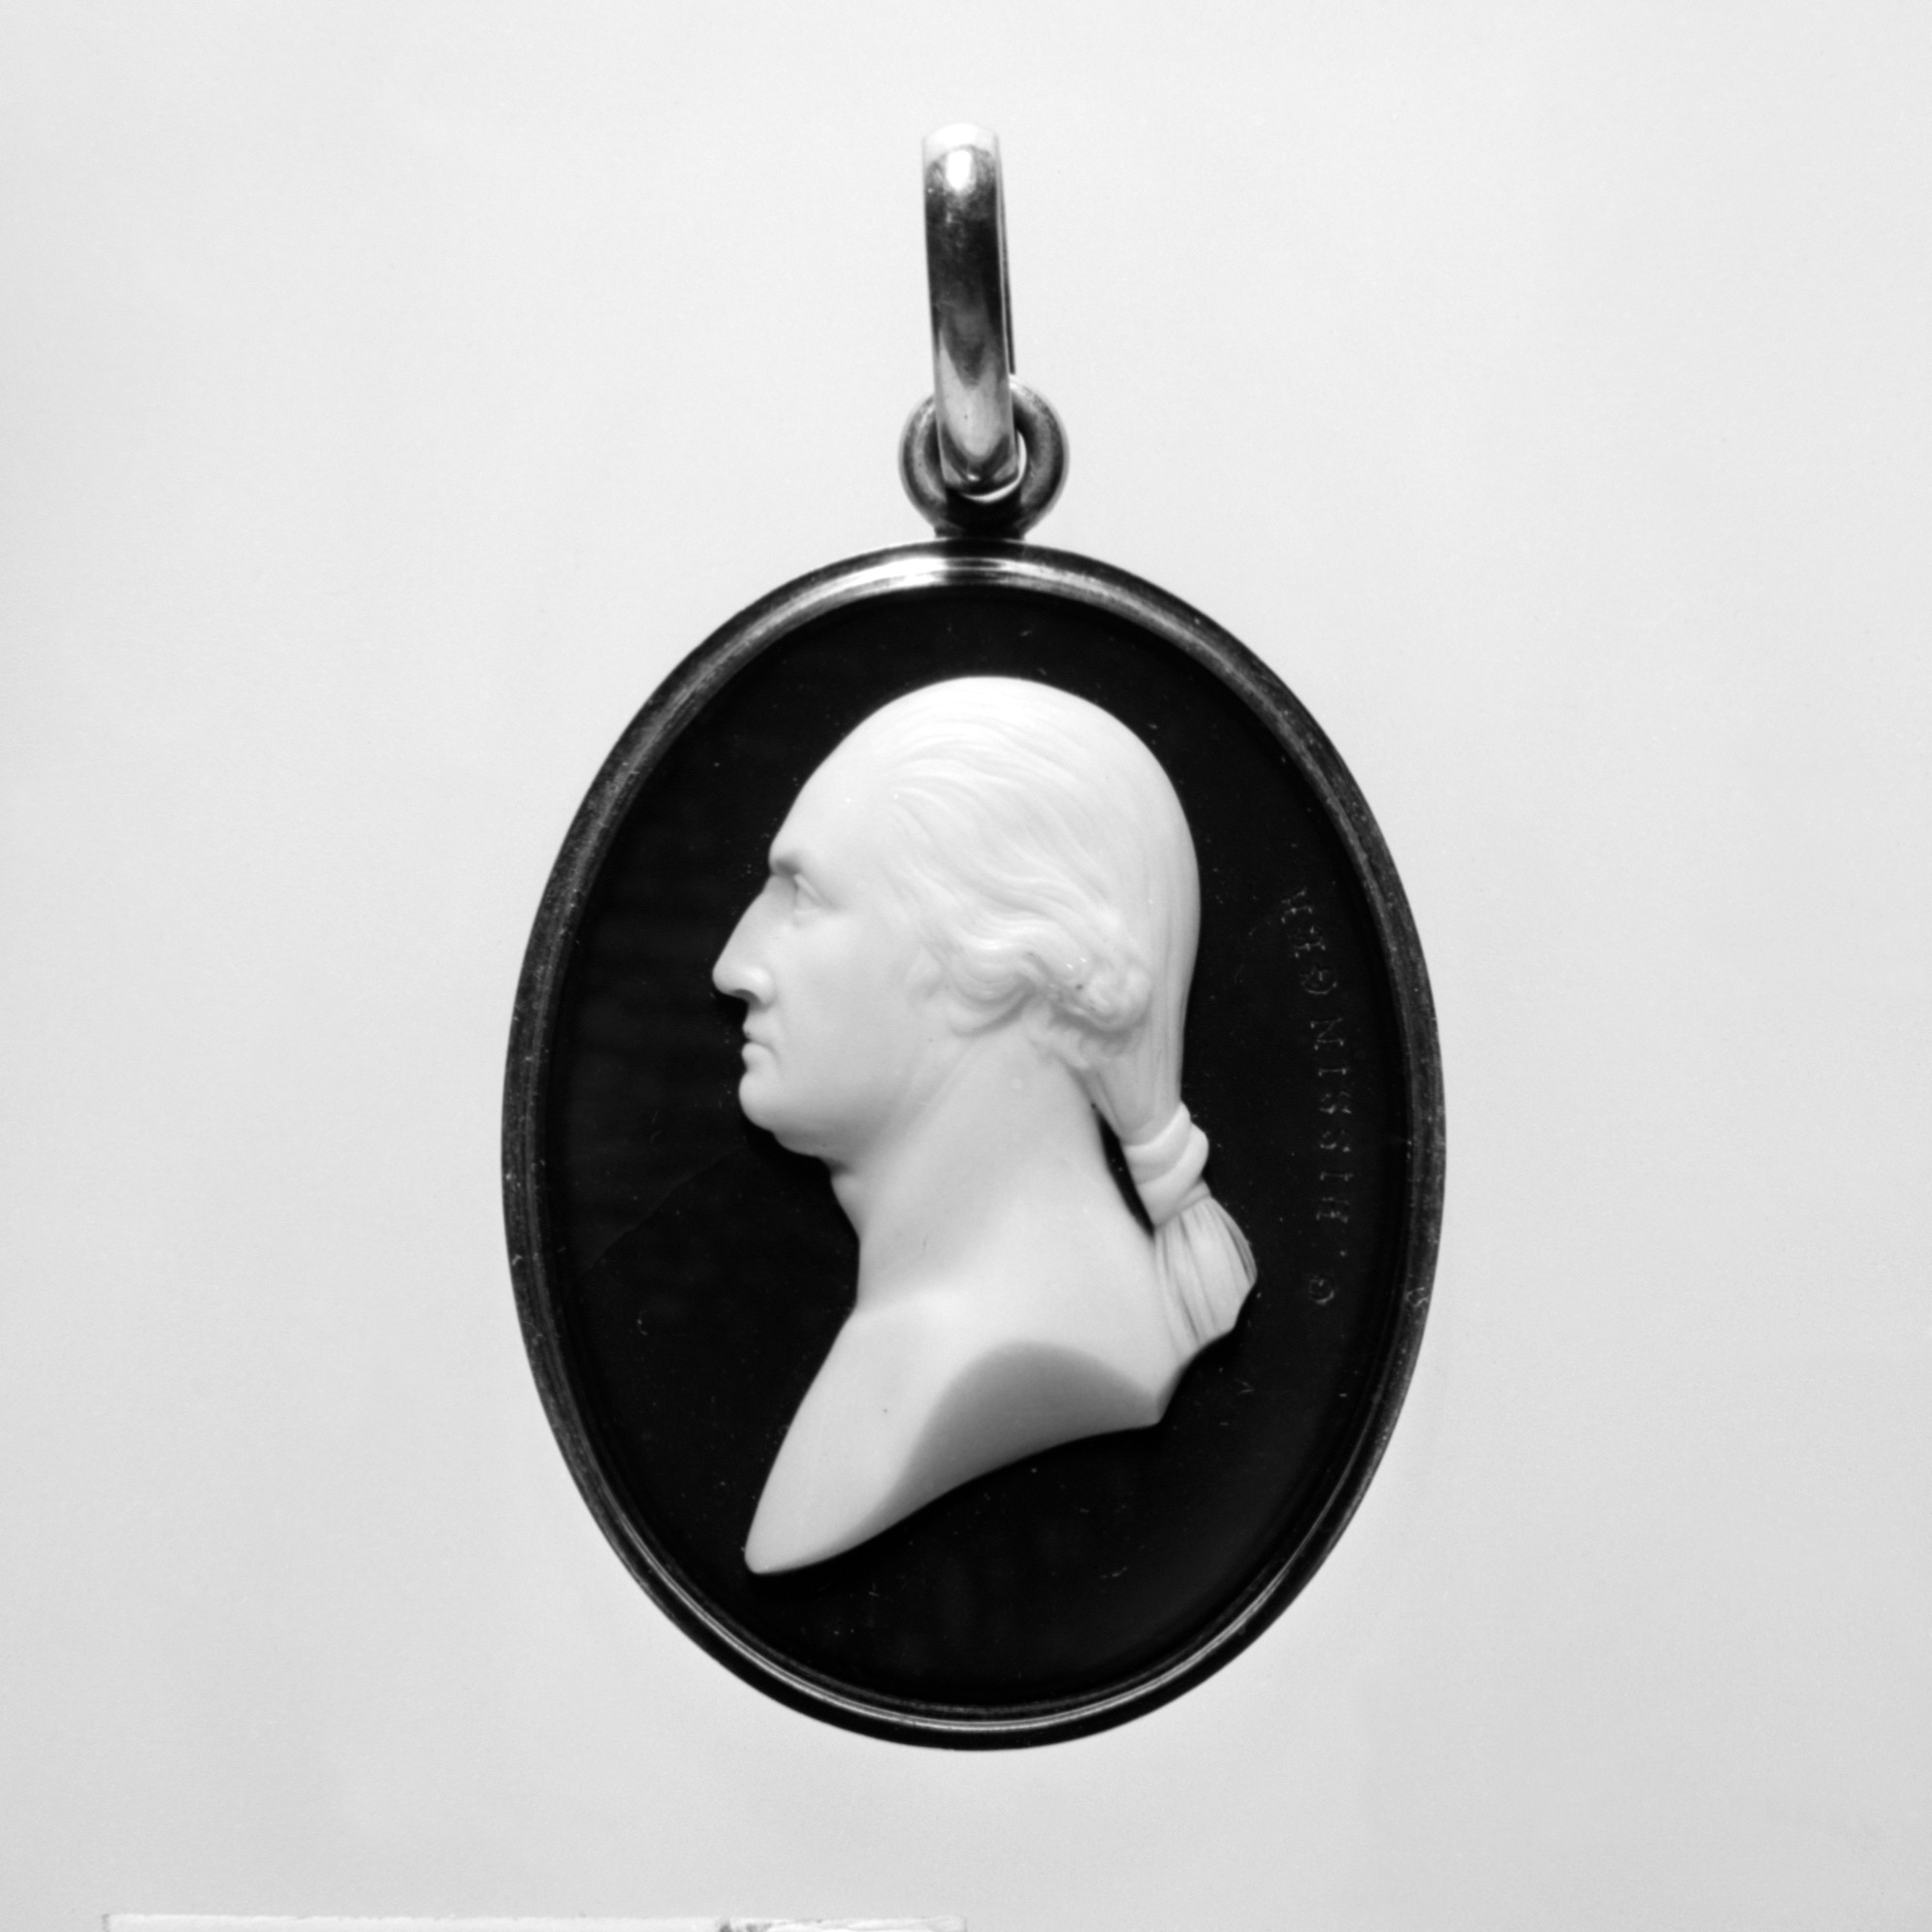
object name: cameo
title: George Washington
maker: george bissinger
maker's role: artist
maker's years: 1848-1908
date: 1851-1900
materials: gold, onyx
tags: george washington,profiles